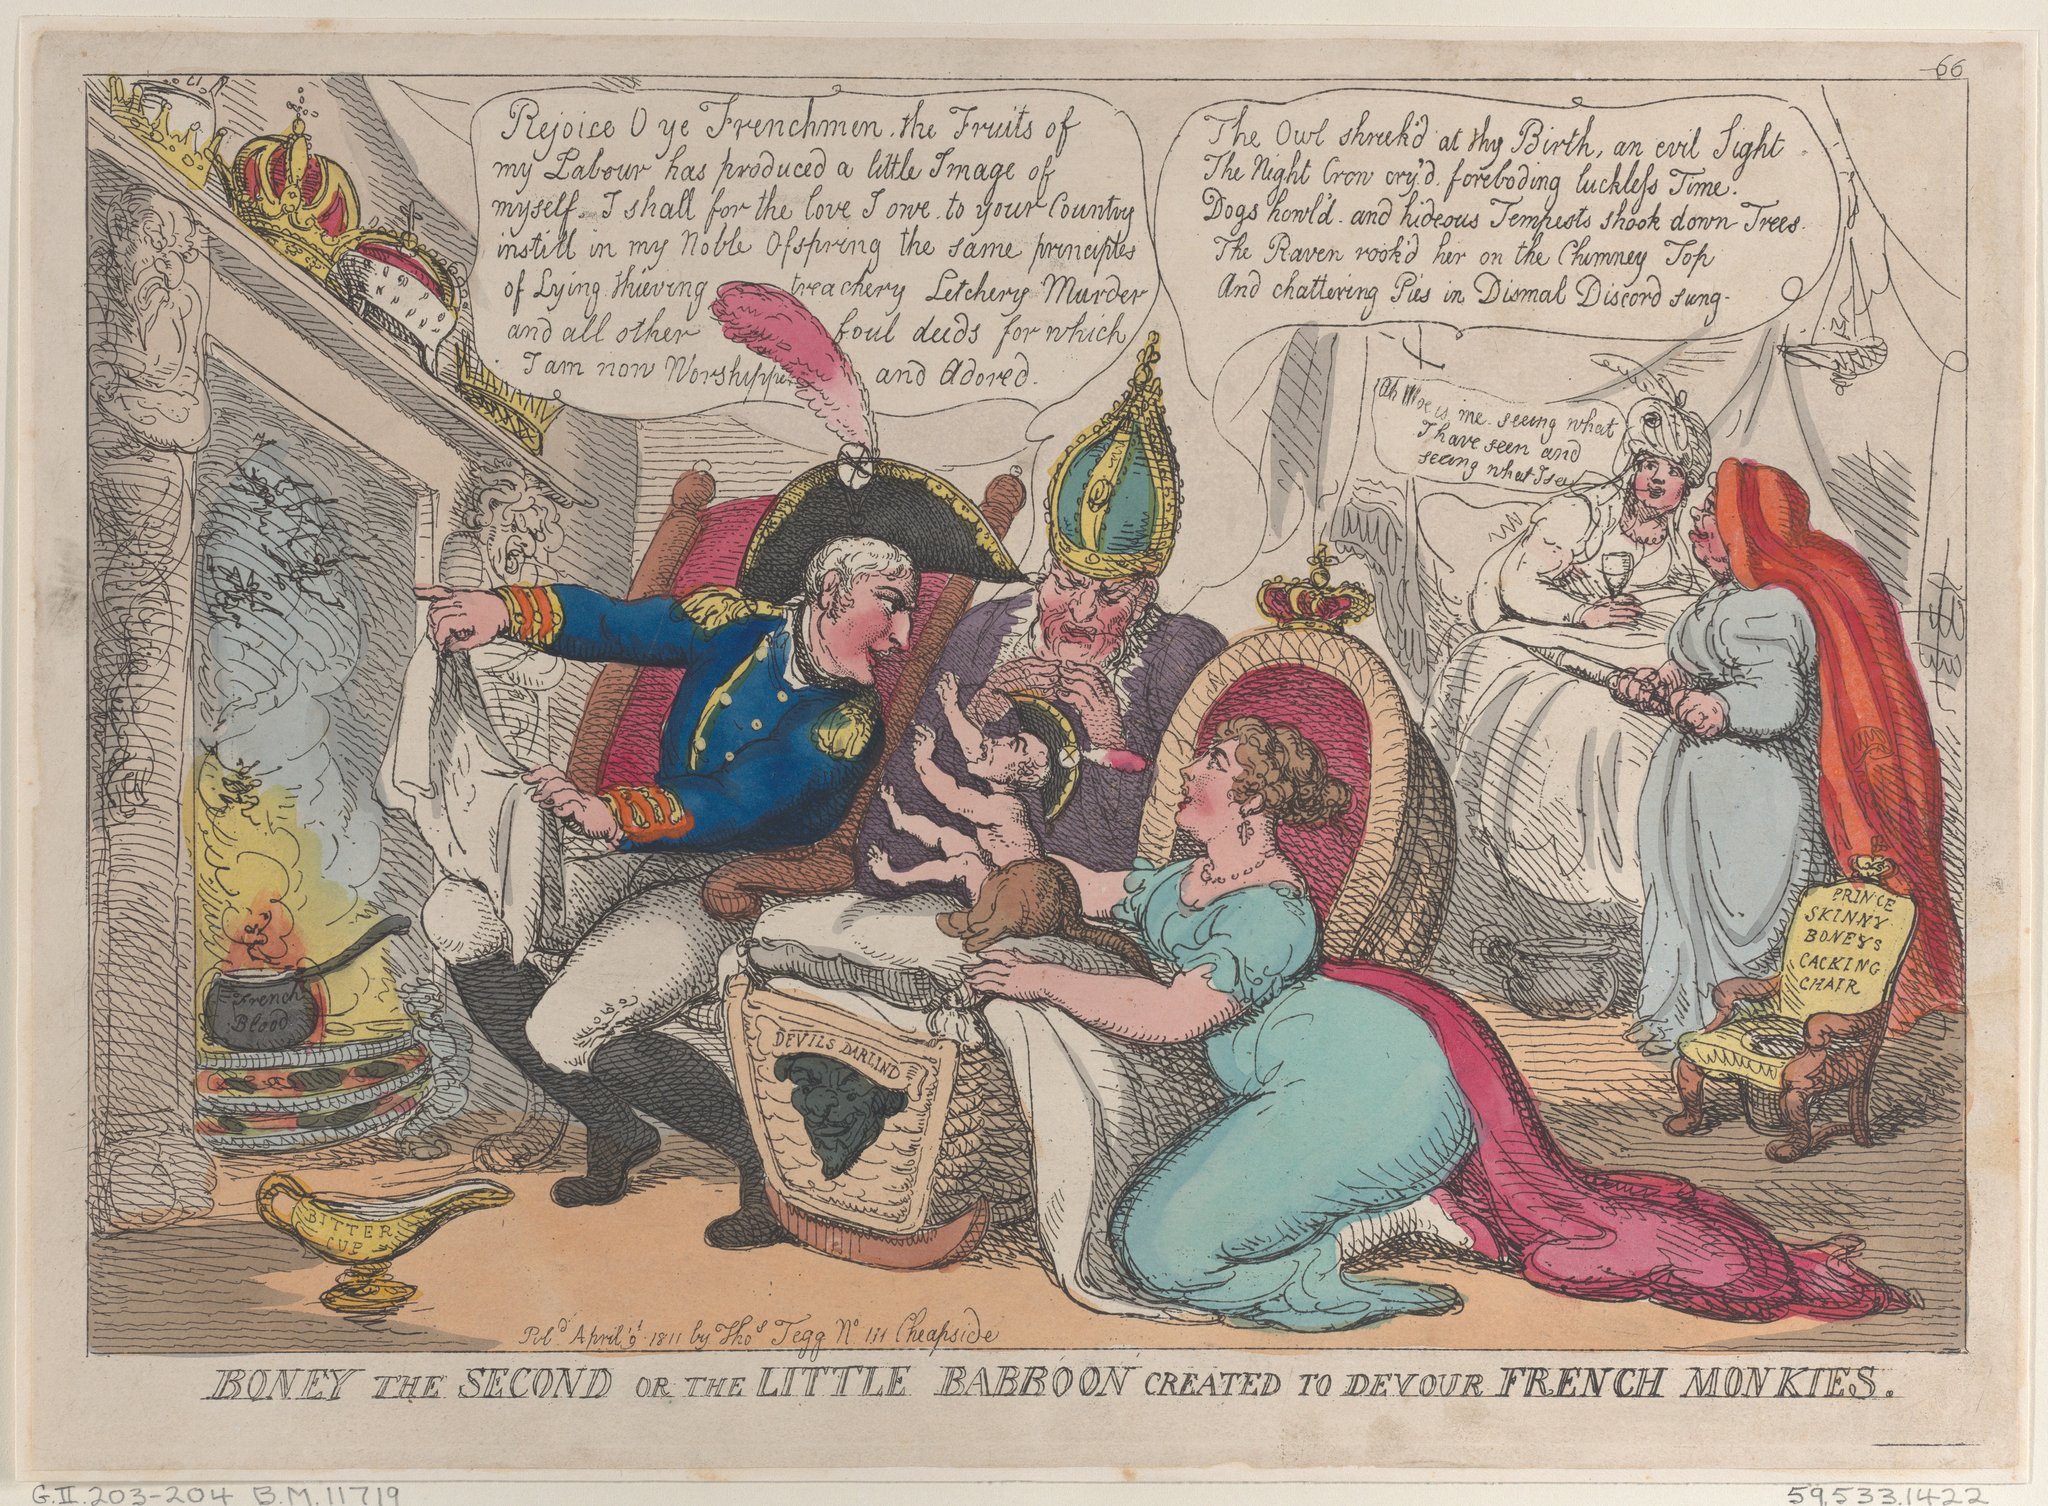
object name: print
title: Boney The Second or the Little Babboon Created to Devour French Monkies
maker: thomas rowlandson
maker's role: artist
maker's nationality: british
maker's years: 1757-1827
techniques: etching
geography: london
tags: napoleon i,men,women,caricature